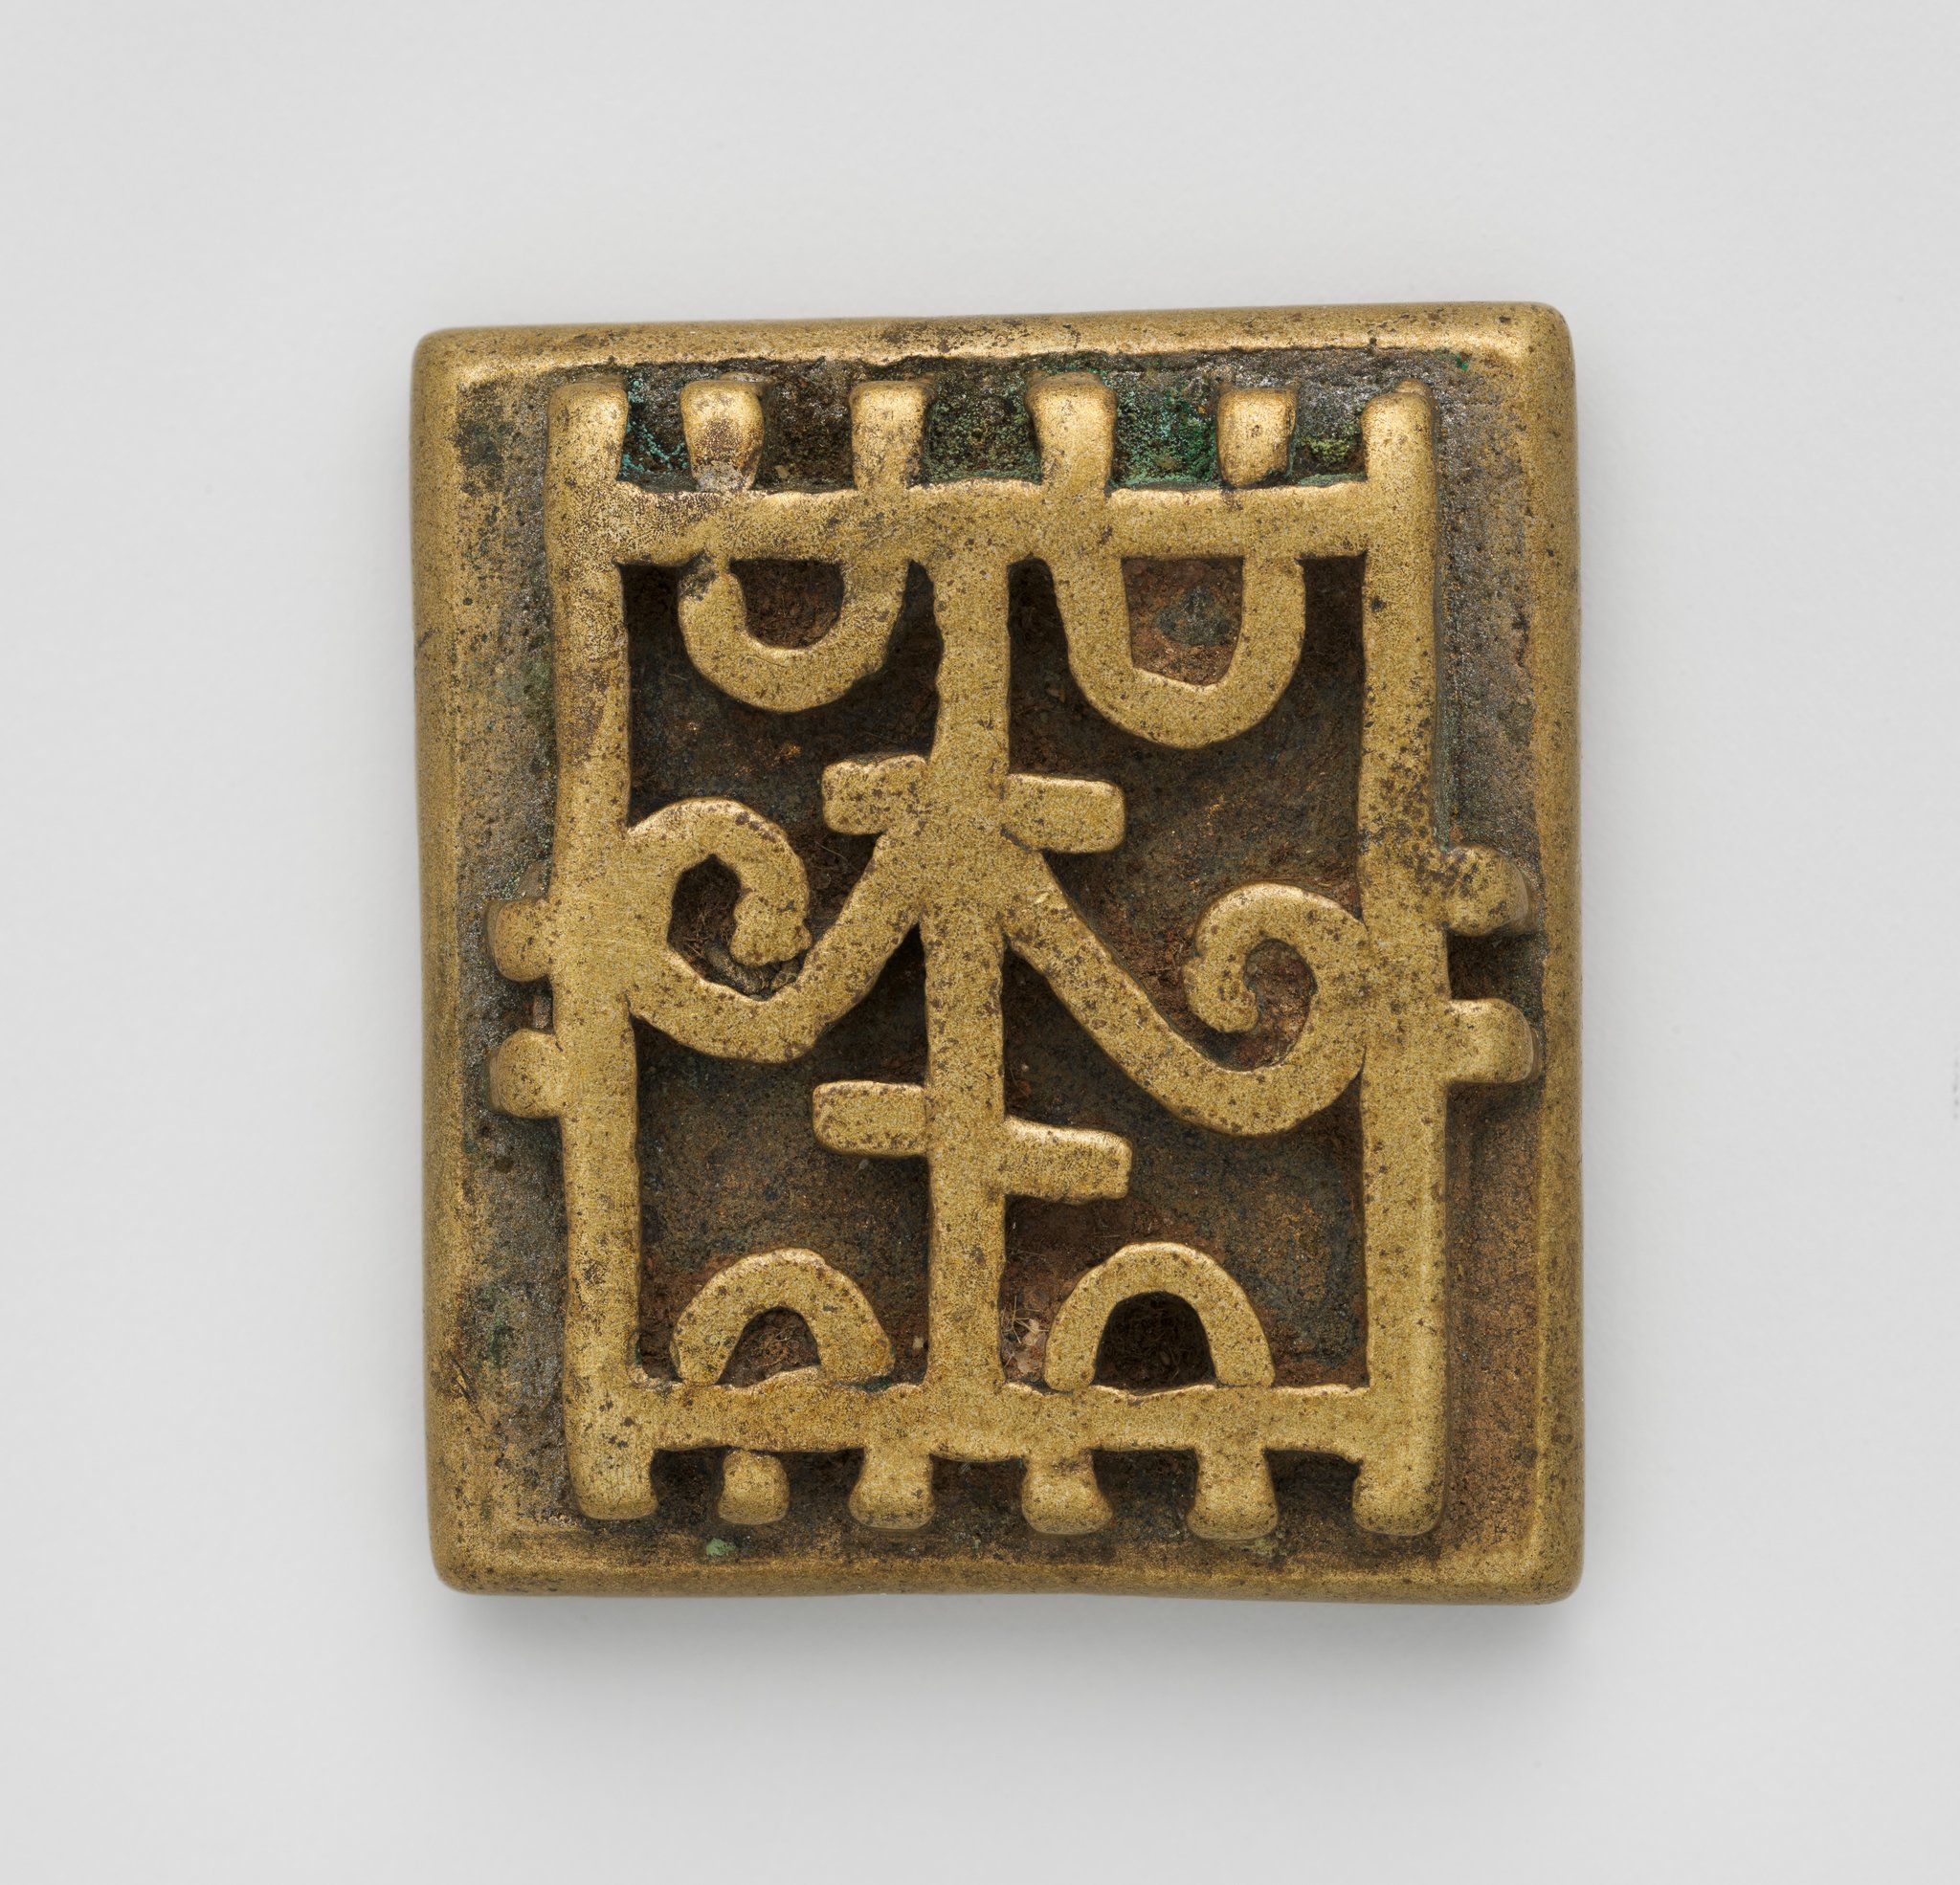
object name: weight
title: Geometric gold weight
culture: akan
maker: akan artist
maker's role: artist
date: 1701-1900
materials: brass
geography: côte d’ivoire